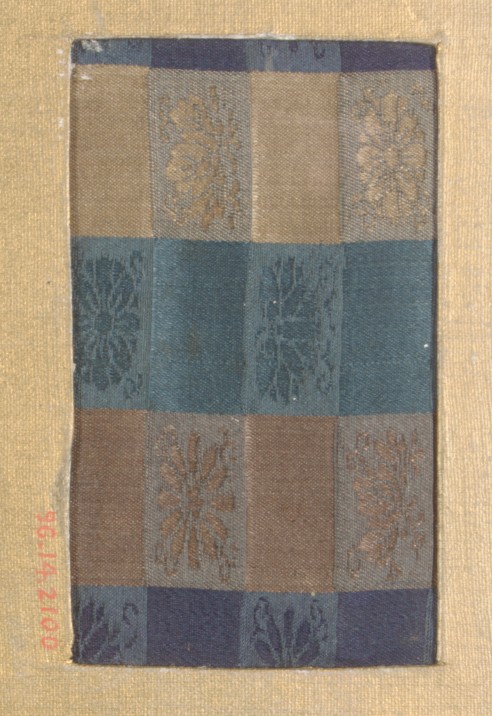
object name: piece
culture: japanese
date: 1701-1900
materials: silk